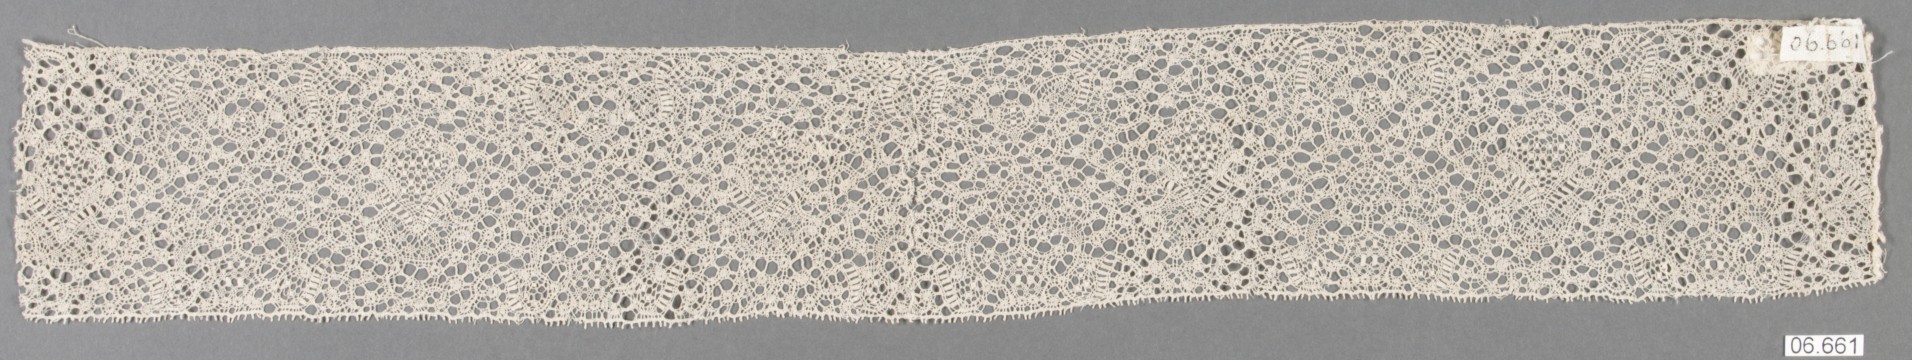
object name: insertion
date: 1700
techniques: lace